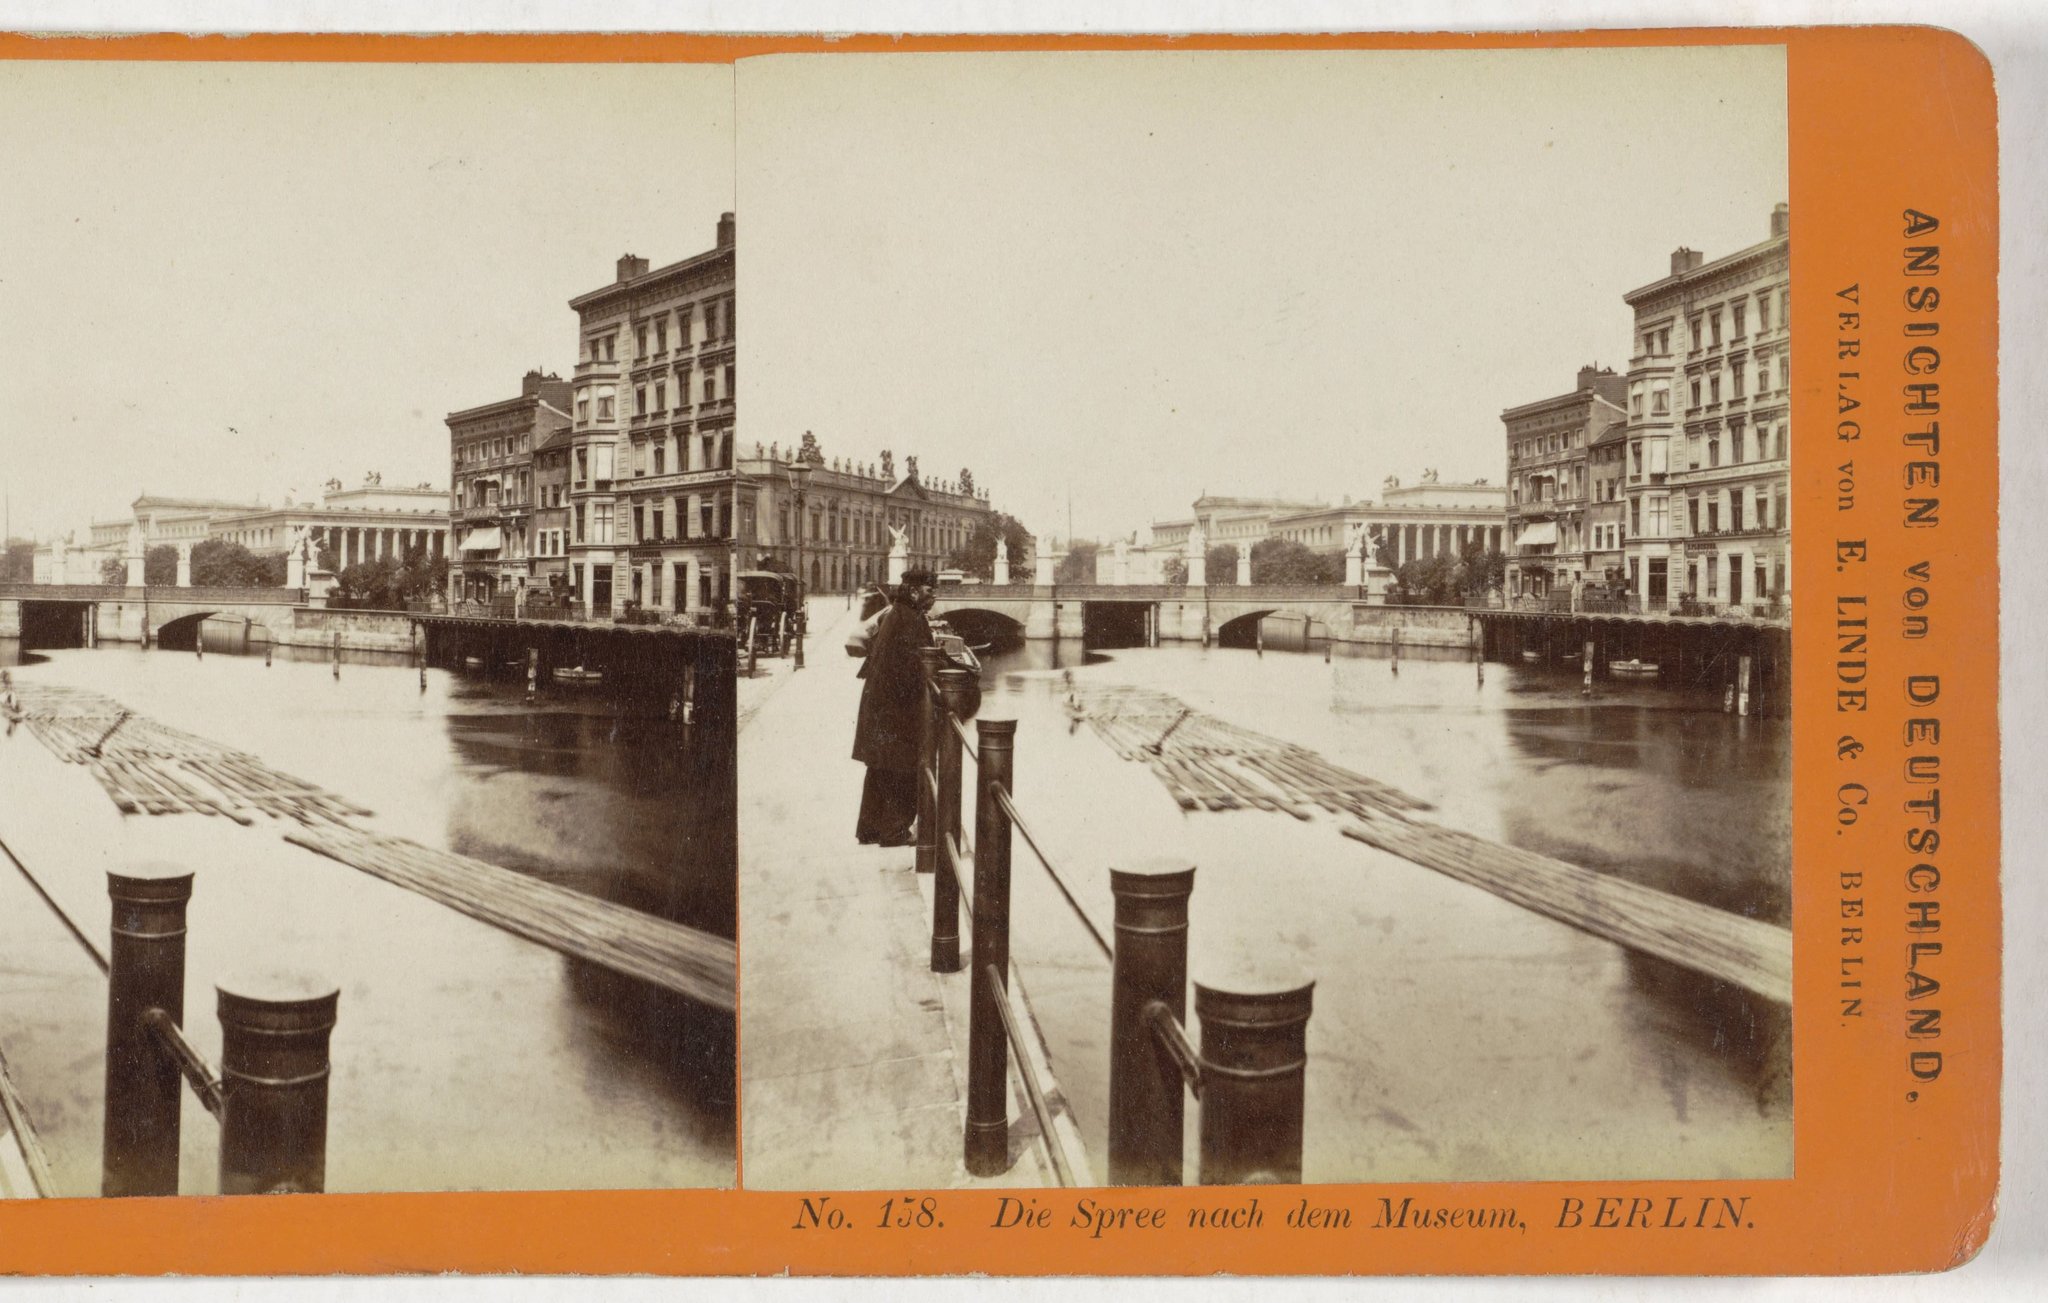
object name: stereograph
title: Ansichten von Deutschland / Berlin und Potsdam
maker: johann friedrich stiehm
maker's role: fotograaf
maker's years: 1826-1902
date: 1868-1870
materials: cardboard, paper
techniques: albumen print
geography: berlin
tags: bridge in city across river, canal, etc., berlin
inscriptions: number: ‘No. 158.’